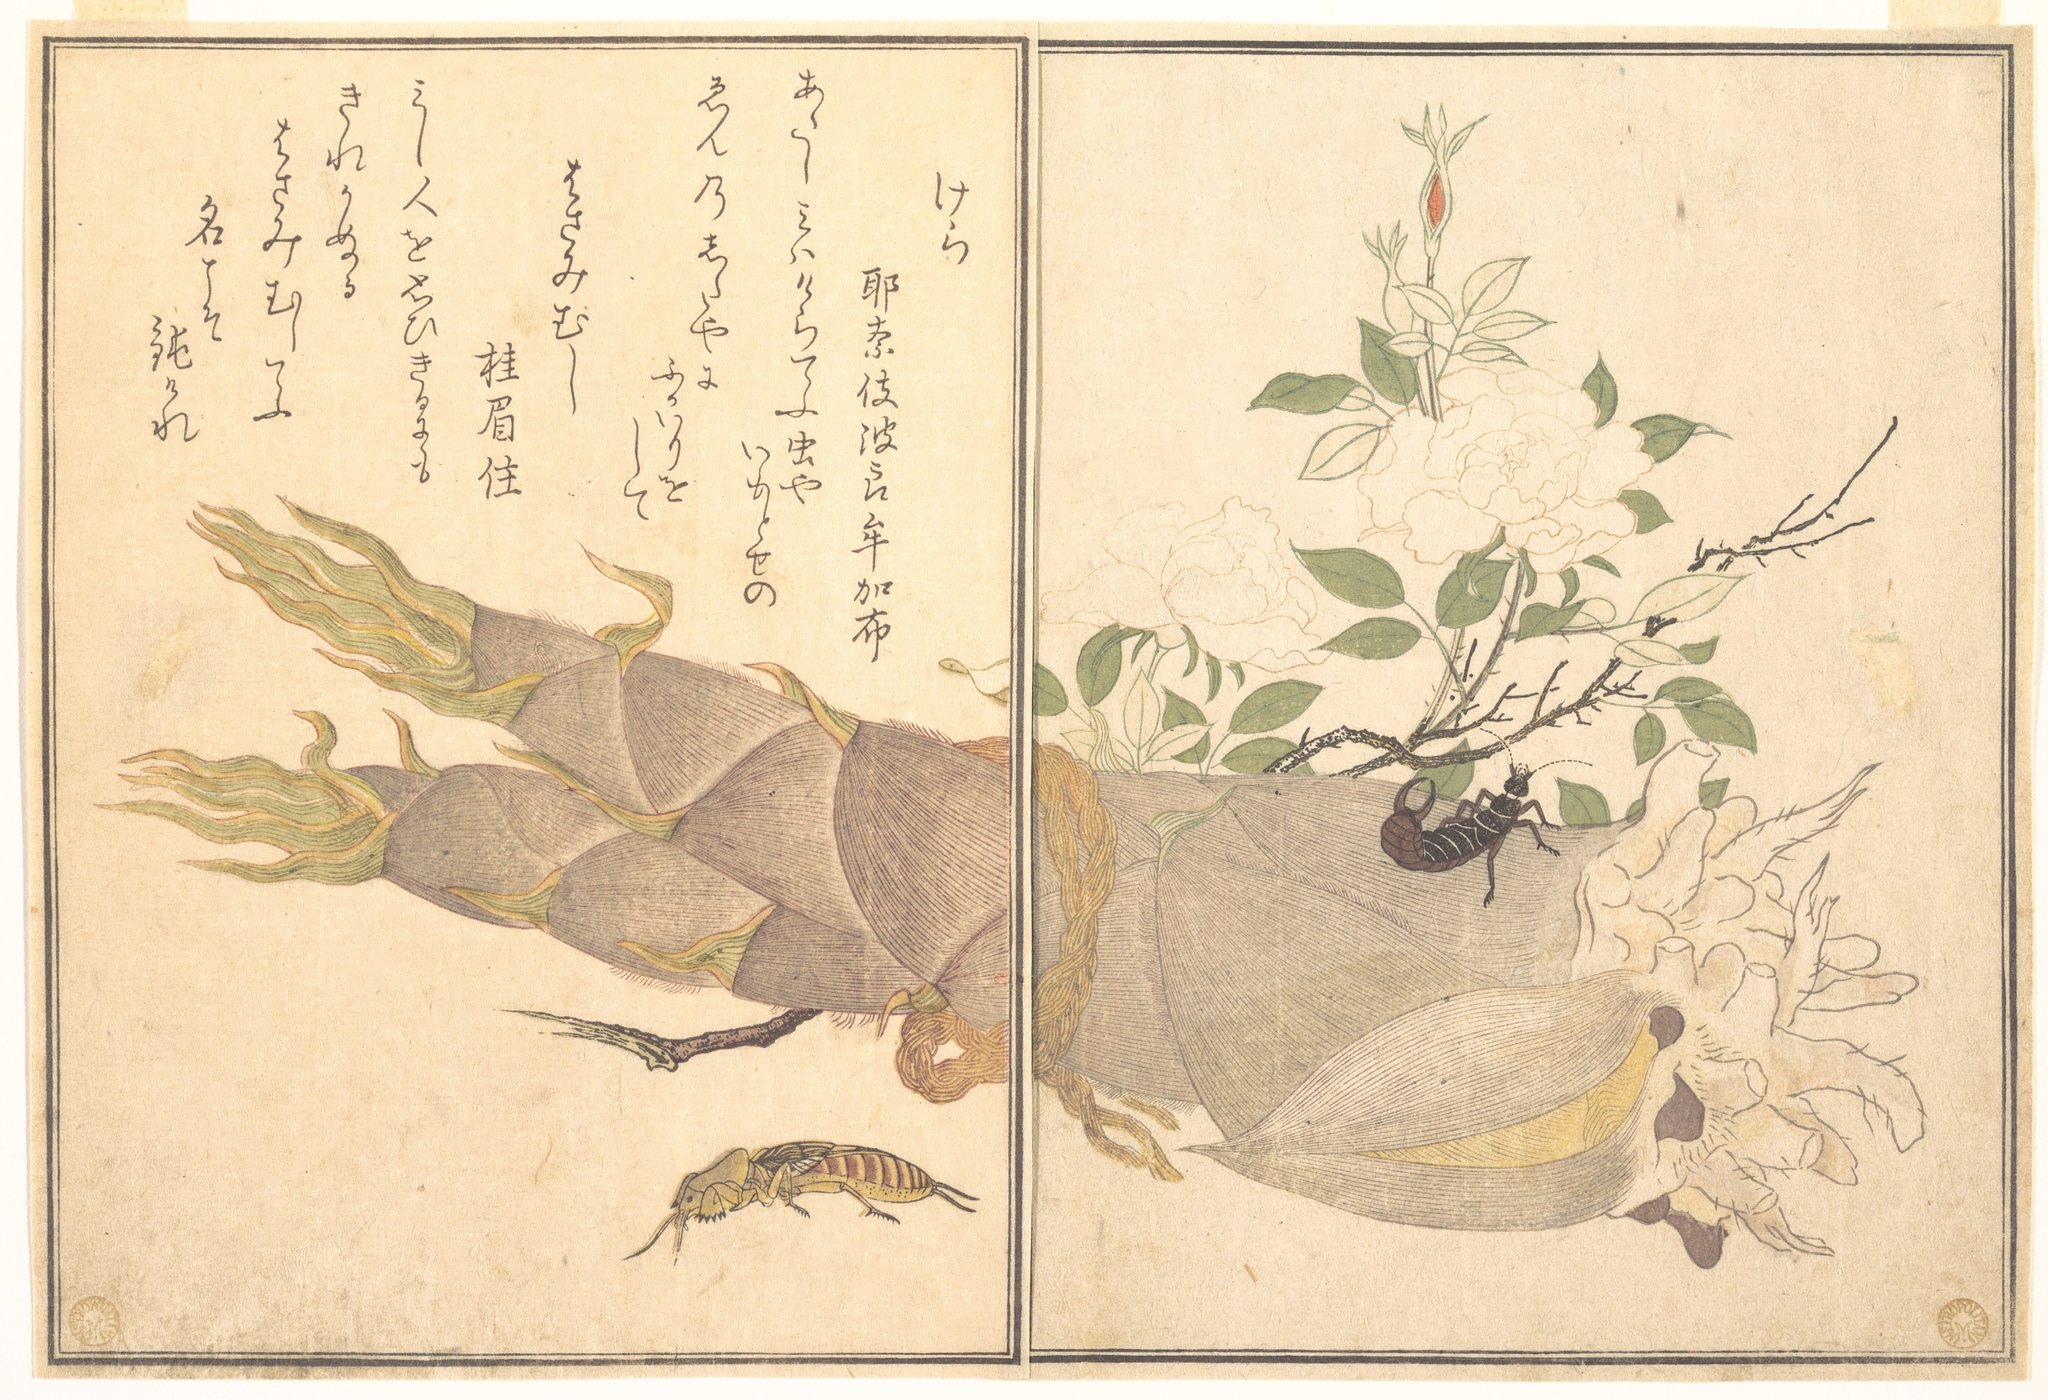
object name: woodblock print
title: Mole Cricket (Kera); Earwig, (Hasami-mushi), from the Picture Book of Crawling Creatures (Ehon mushi erami)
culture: japanese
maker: kitagawa utamaro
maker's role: artist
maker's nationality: japanese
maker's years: 1754-1806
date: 1788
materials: ink, paper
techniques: woodblock print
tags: insects,flowers,leaves